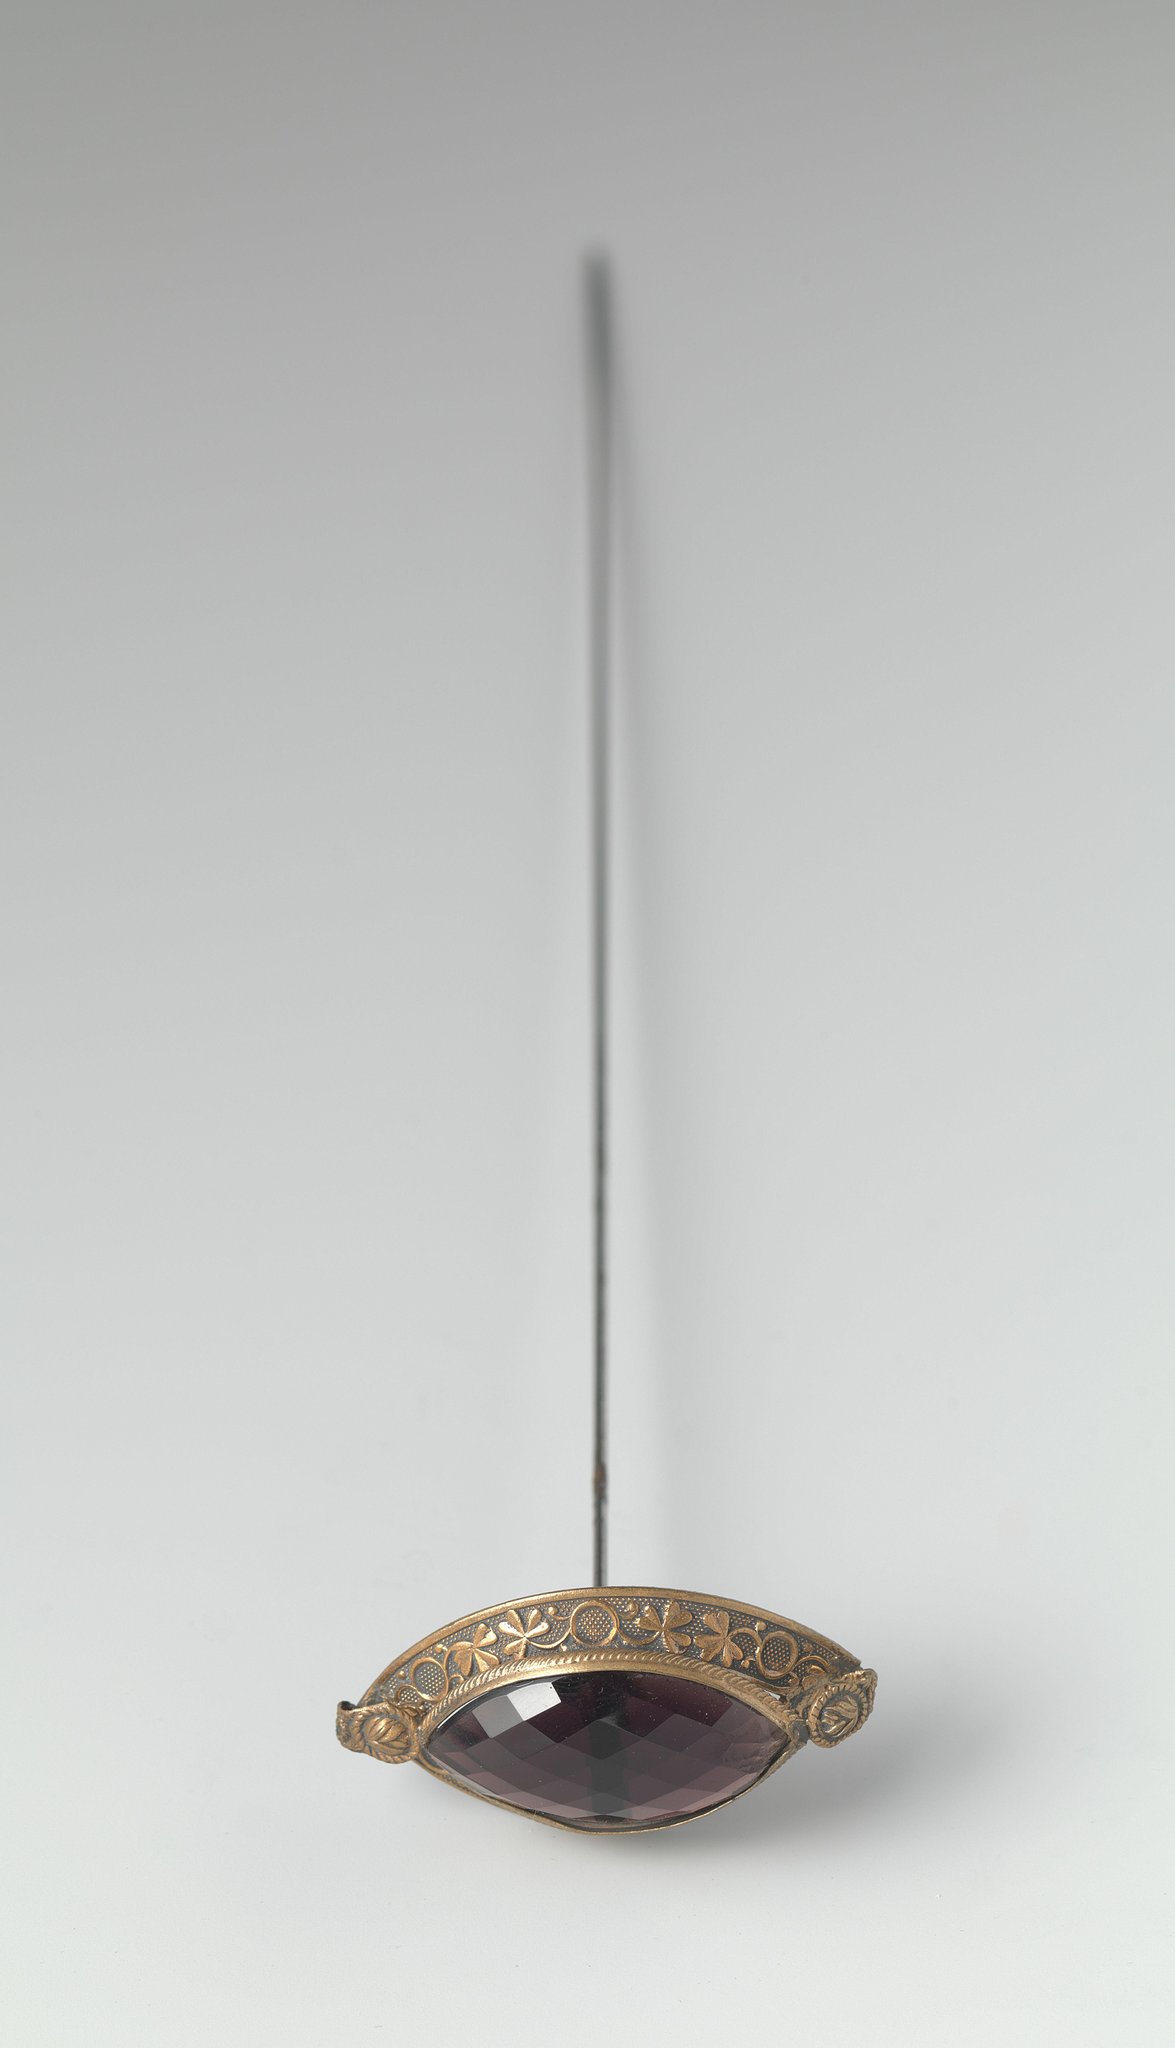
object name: hatpin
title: Hoedenspeld met ovale versiering van bewerkt koper waarin een spitsovale, geslepen paarse steen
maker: Anonymous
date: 1900-1912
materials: copper, glass, metal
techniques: forging, grinding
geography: netherlands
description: Hoedenspeld met ovale versiering van bewerkt koper waarin een spitsovale, geslepen paarse steen.